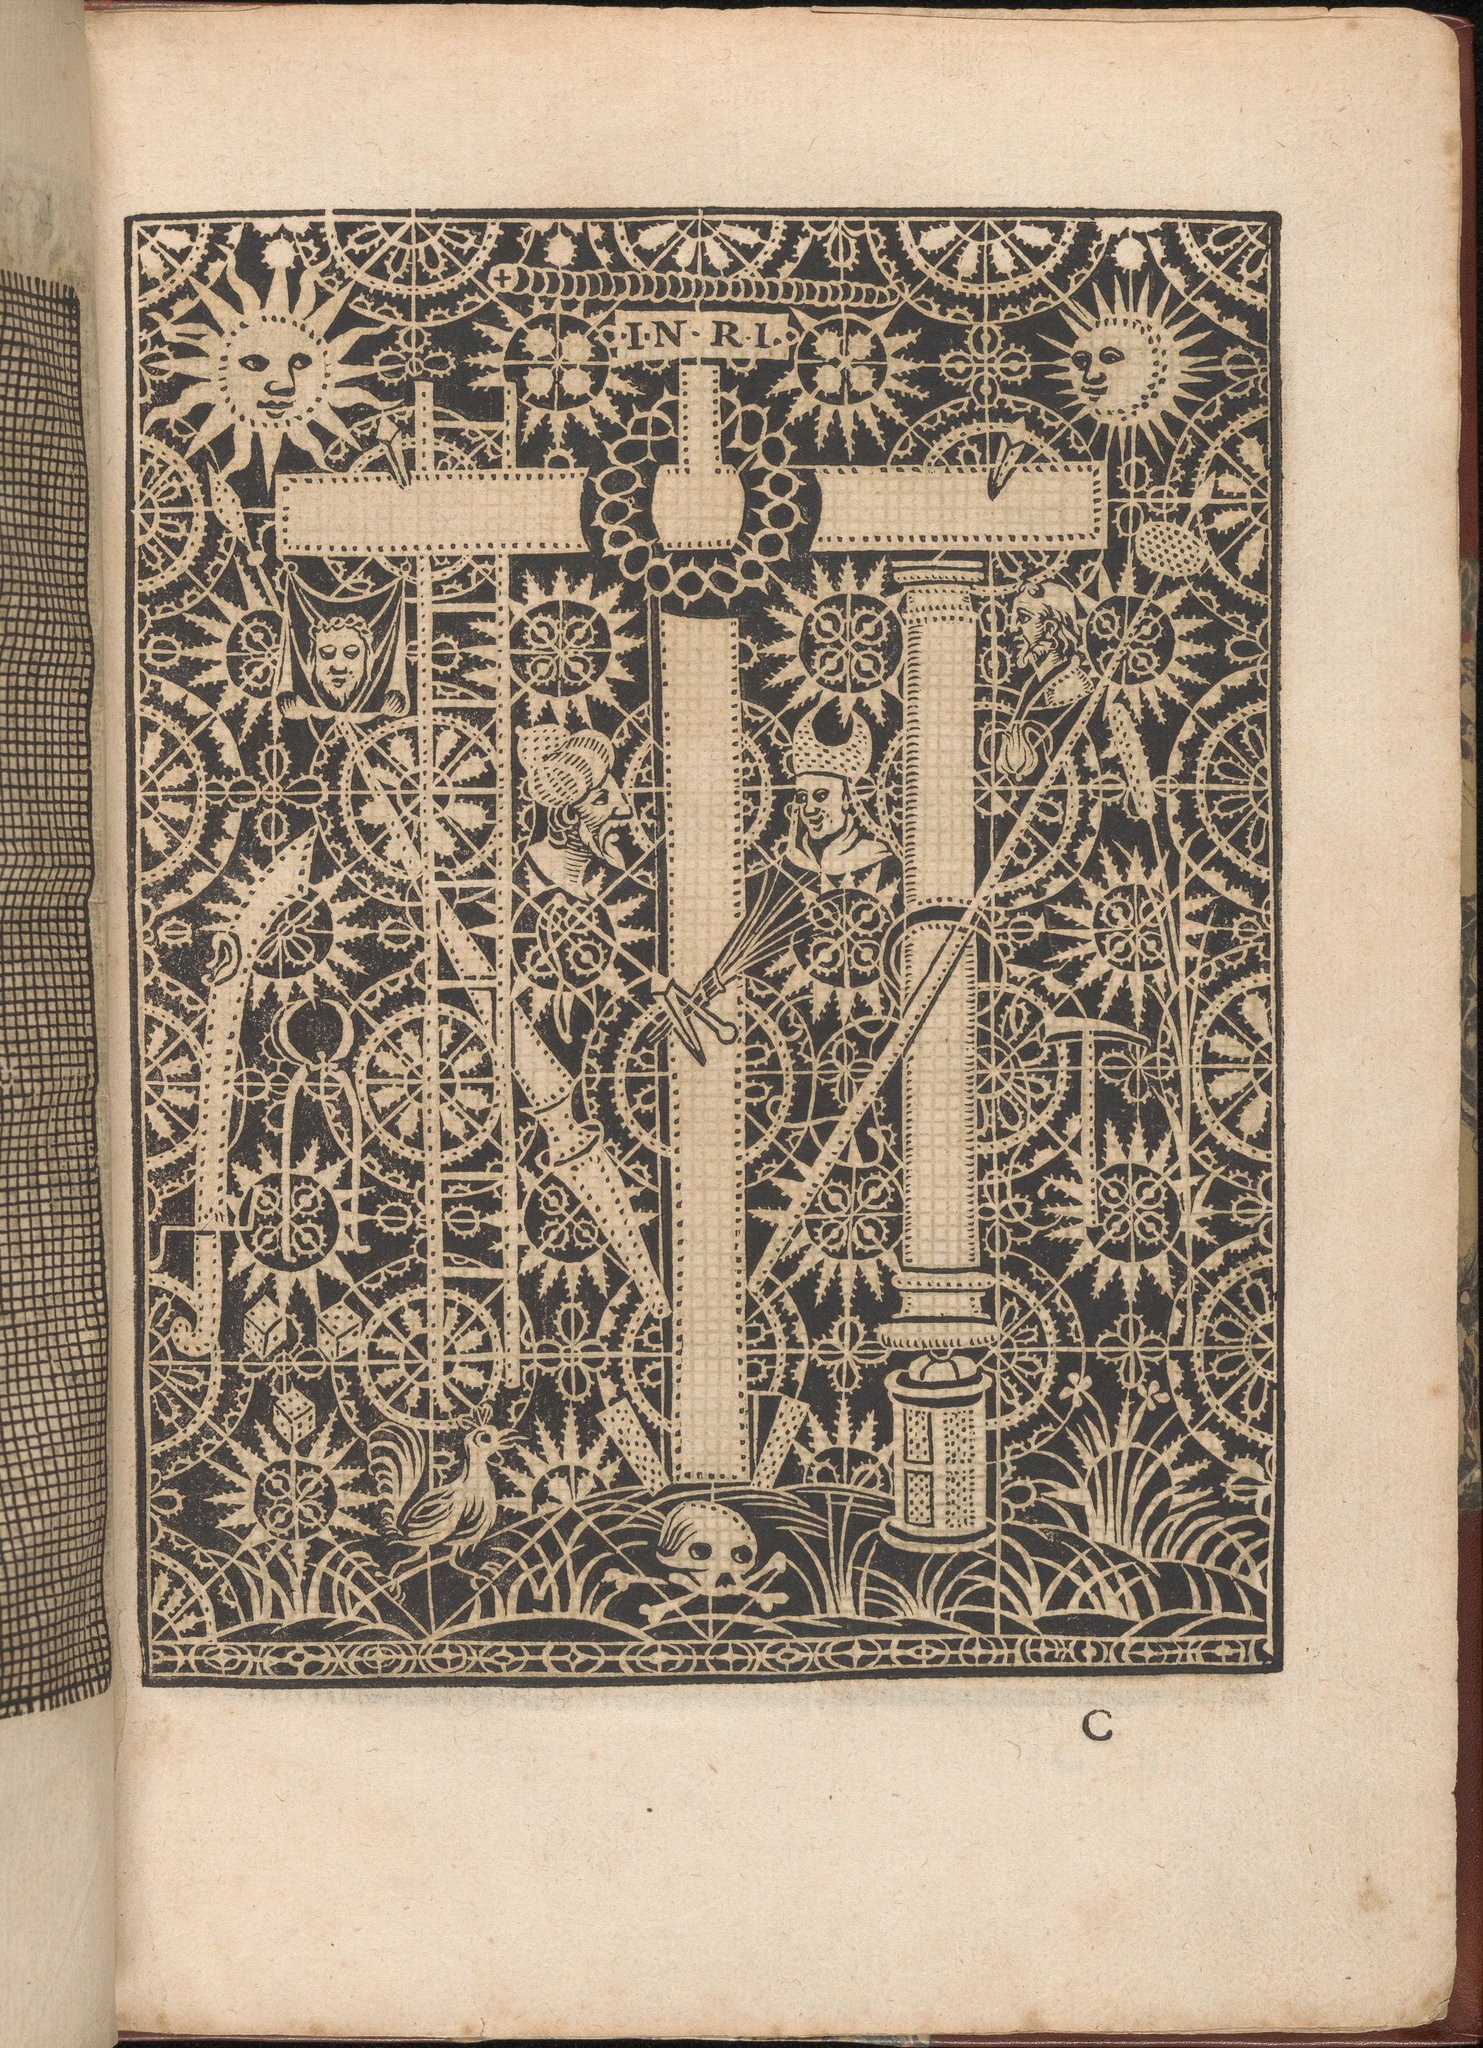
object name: book print ornament architecture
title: Les Secondes Oeuvres, et Subtiles Inventions De Lingerie du Seigneur Federic de Vinciolo Venitien, page 9 (recto)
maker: federico de vinciolo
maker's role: designer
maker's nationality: italian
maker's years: 1582-1599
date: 1603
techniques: woodcut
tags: ornament